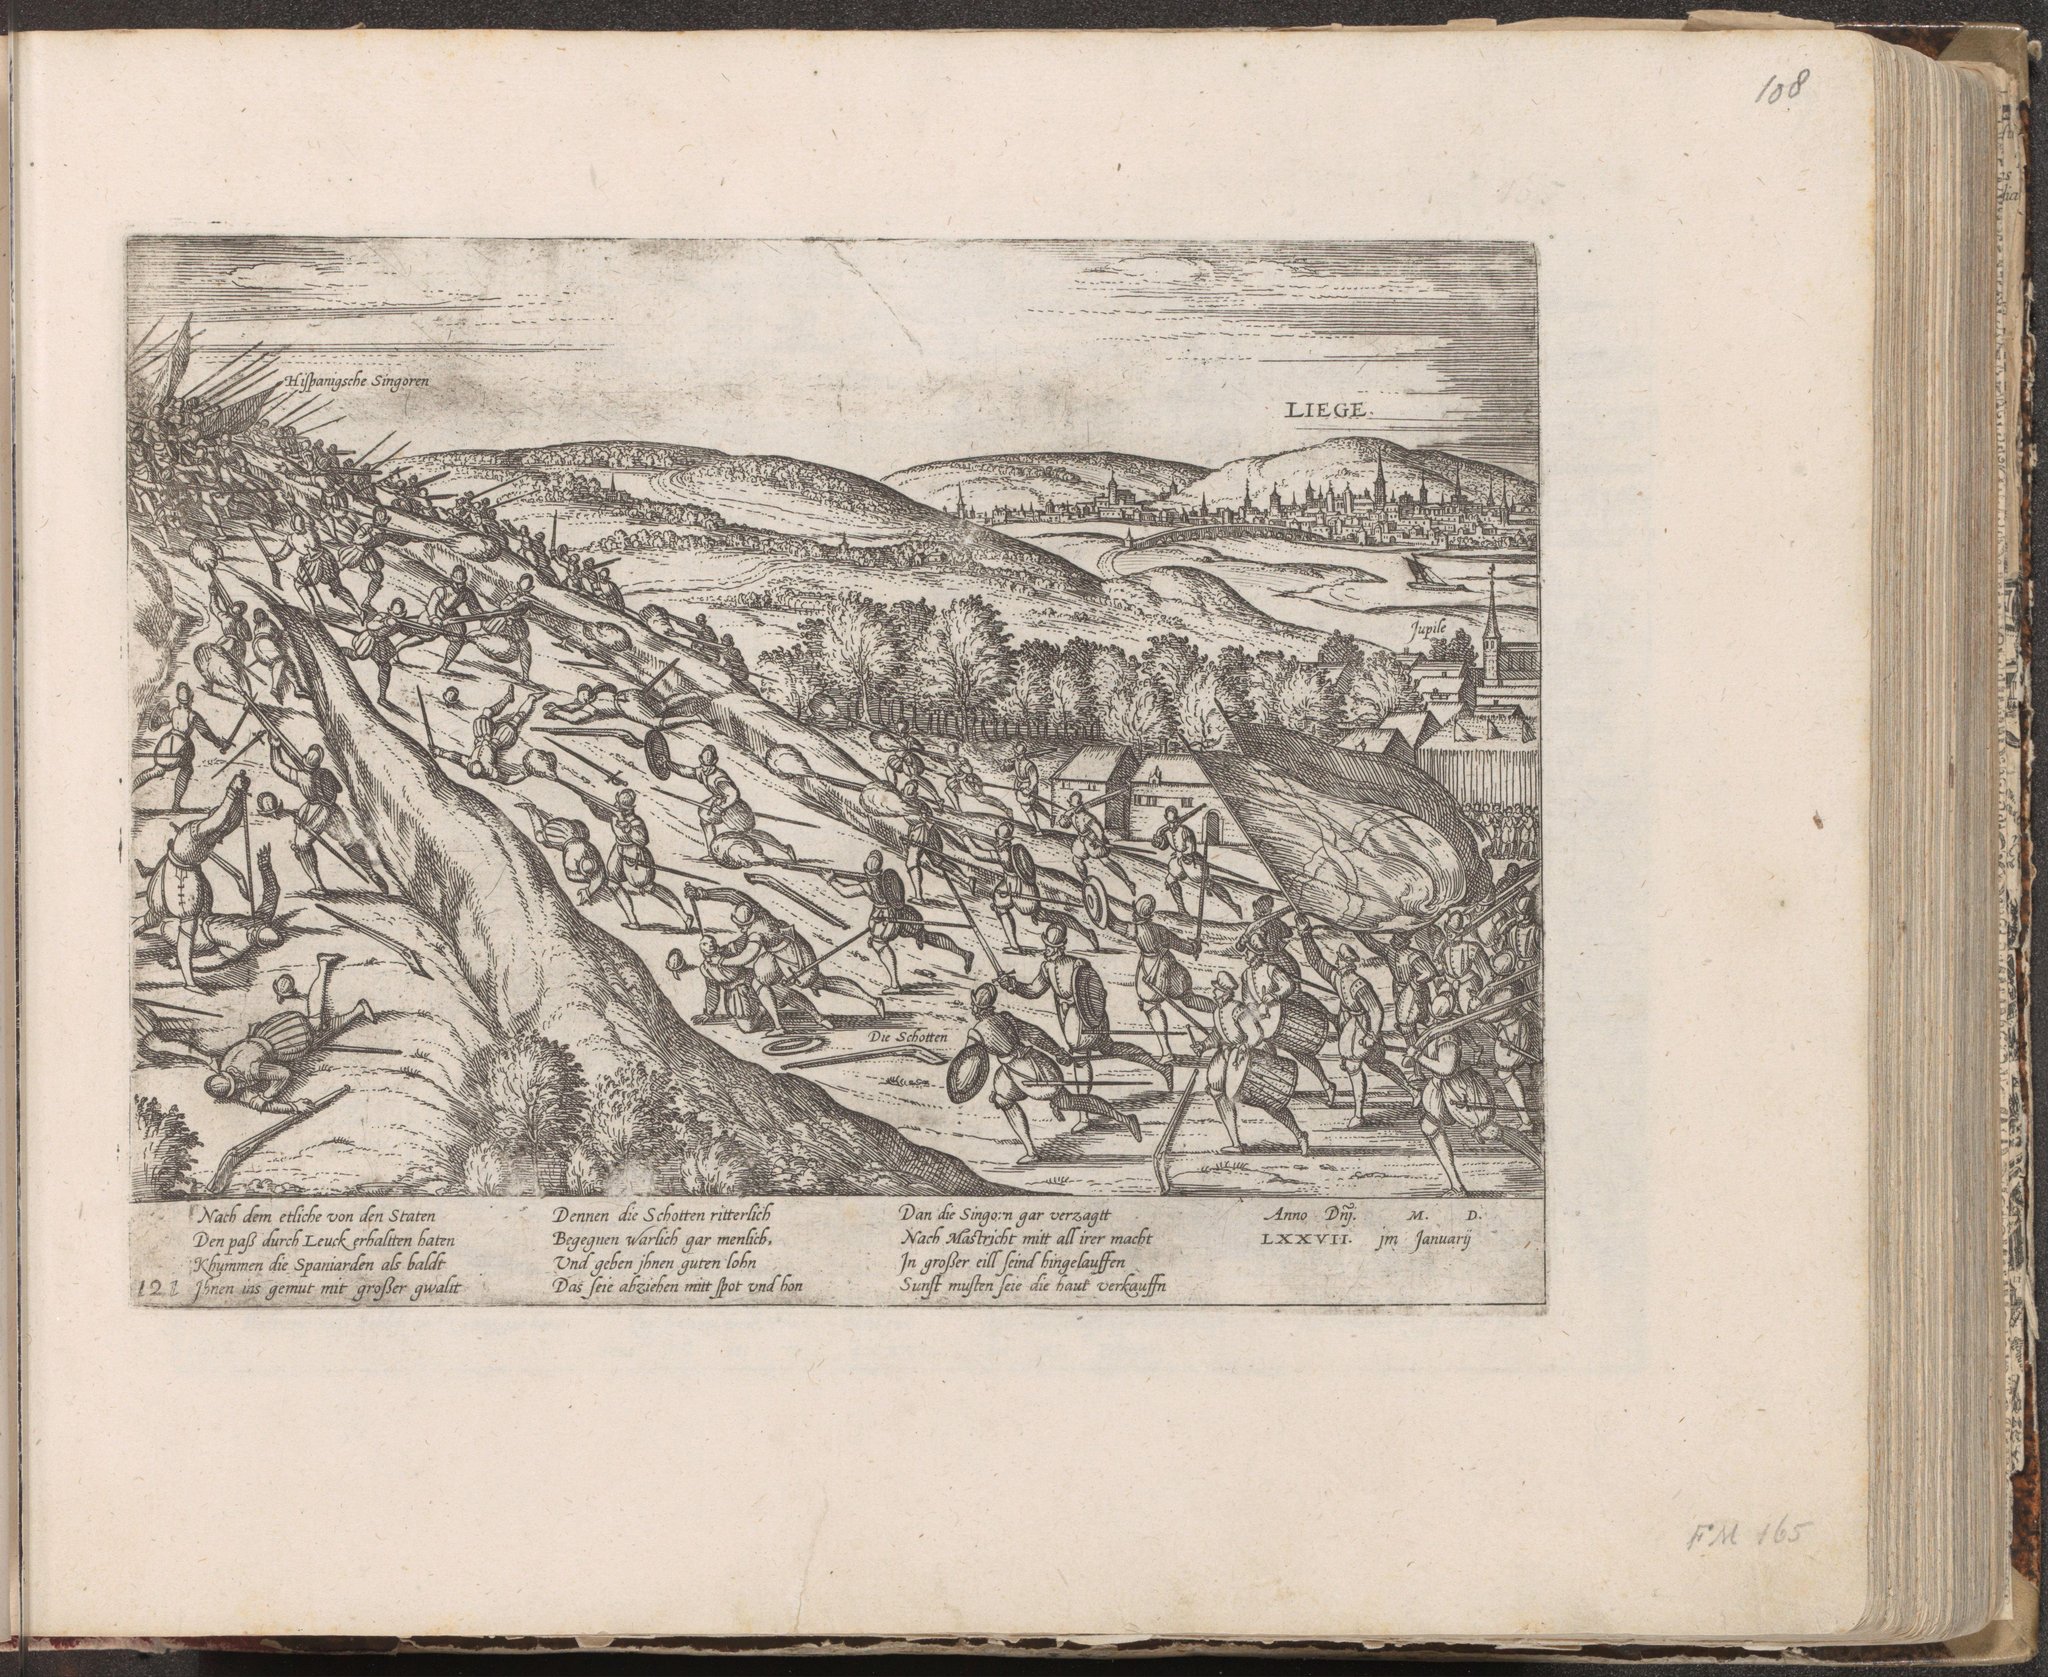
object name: album leaf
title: Serie 7: Nederlandse Gebeurtenissen, 1576-1577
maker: frans hogenberg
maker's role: print maker, publisher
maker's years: 1538-1590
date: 1577-1579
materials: paper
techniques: etching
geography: cologne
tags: battle (+ land forces), liège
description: Spanjaarden door de Schotten verslagen en verjaagd tijdens een veldslag bij Luik, januari 1577. Met onderschrift van 12 regels in het Duits. Linksonder genummerd: 121. De prent maakt deel uit van een album.